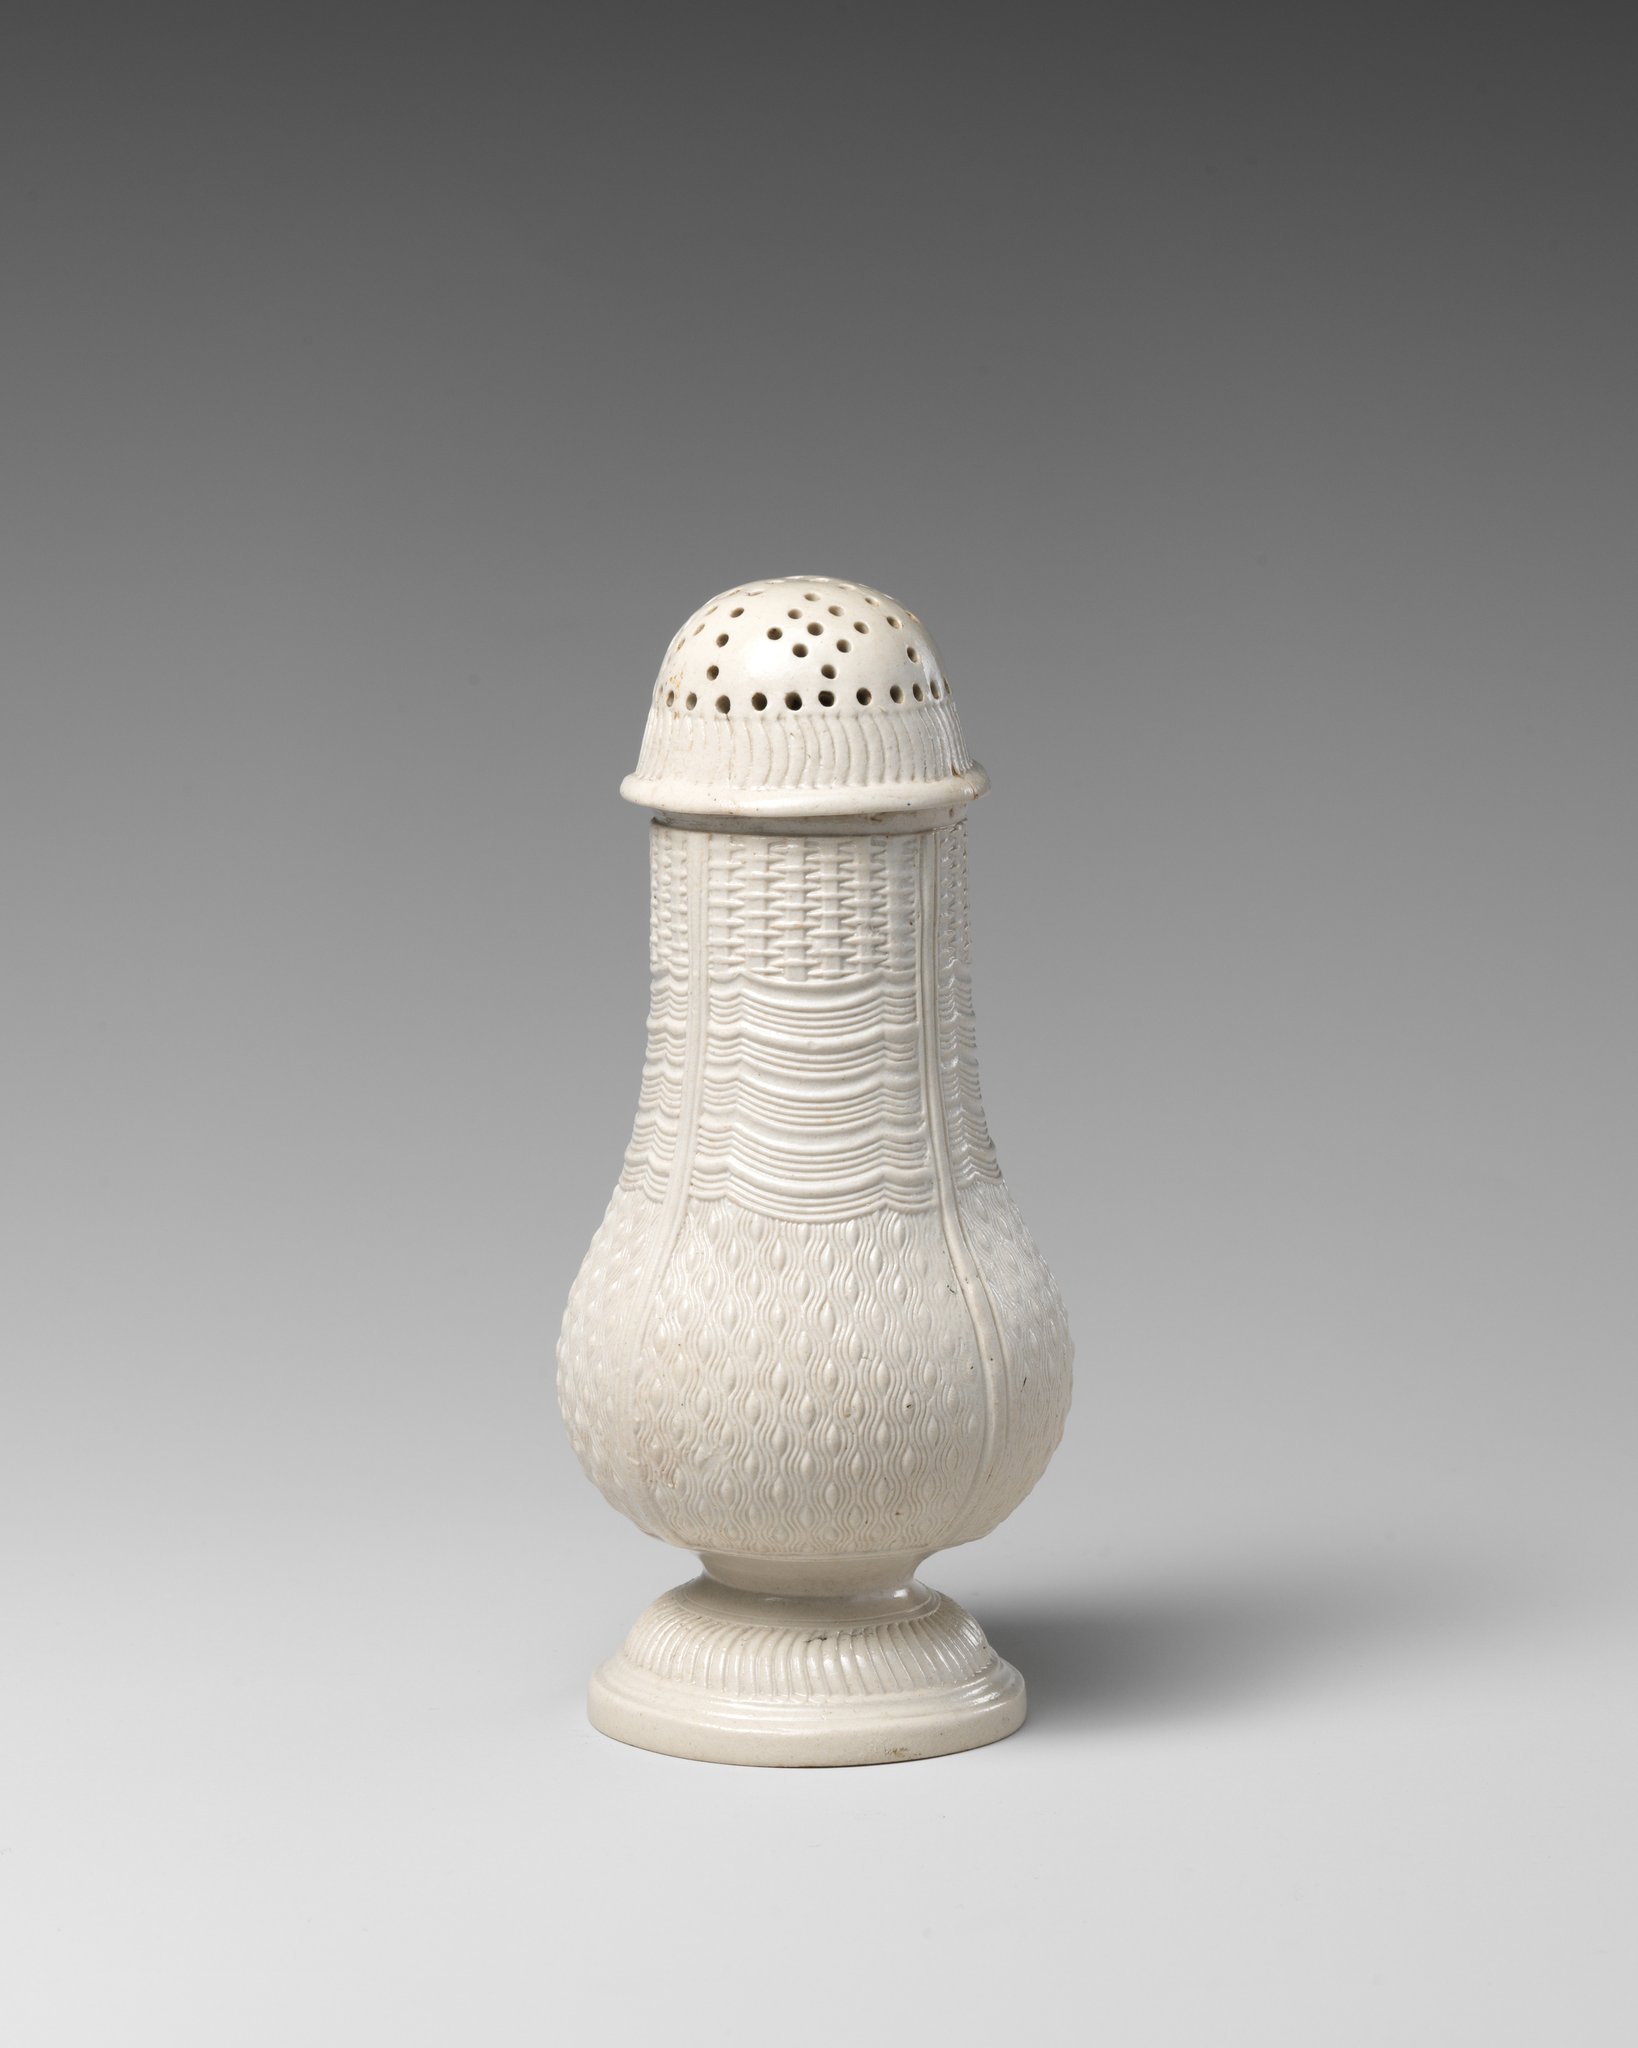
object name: caster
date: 1760-1780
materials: stoneware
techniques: salt glaze